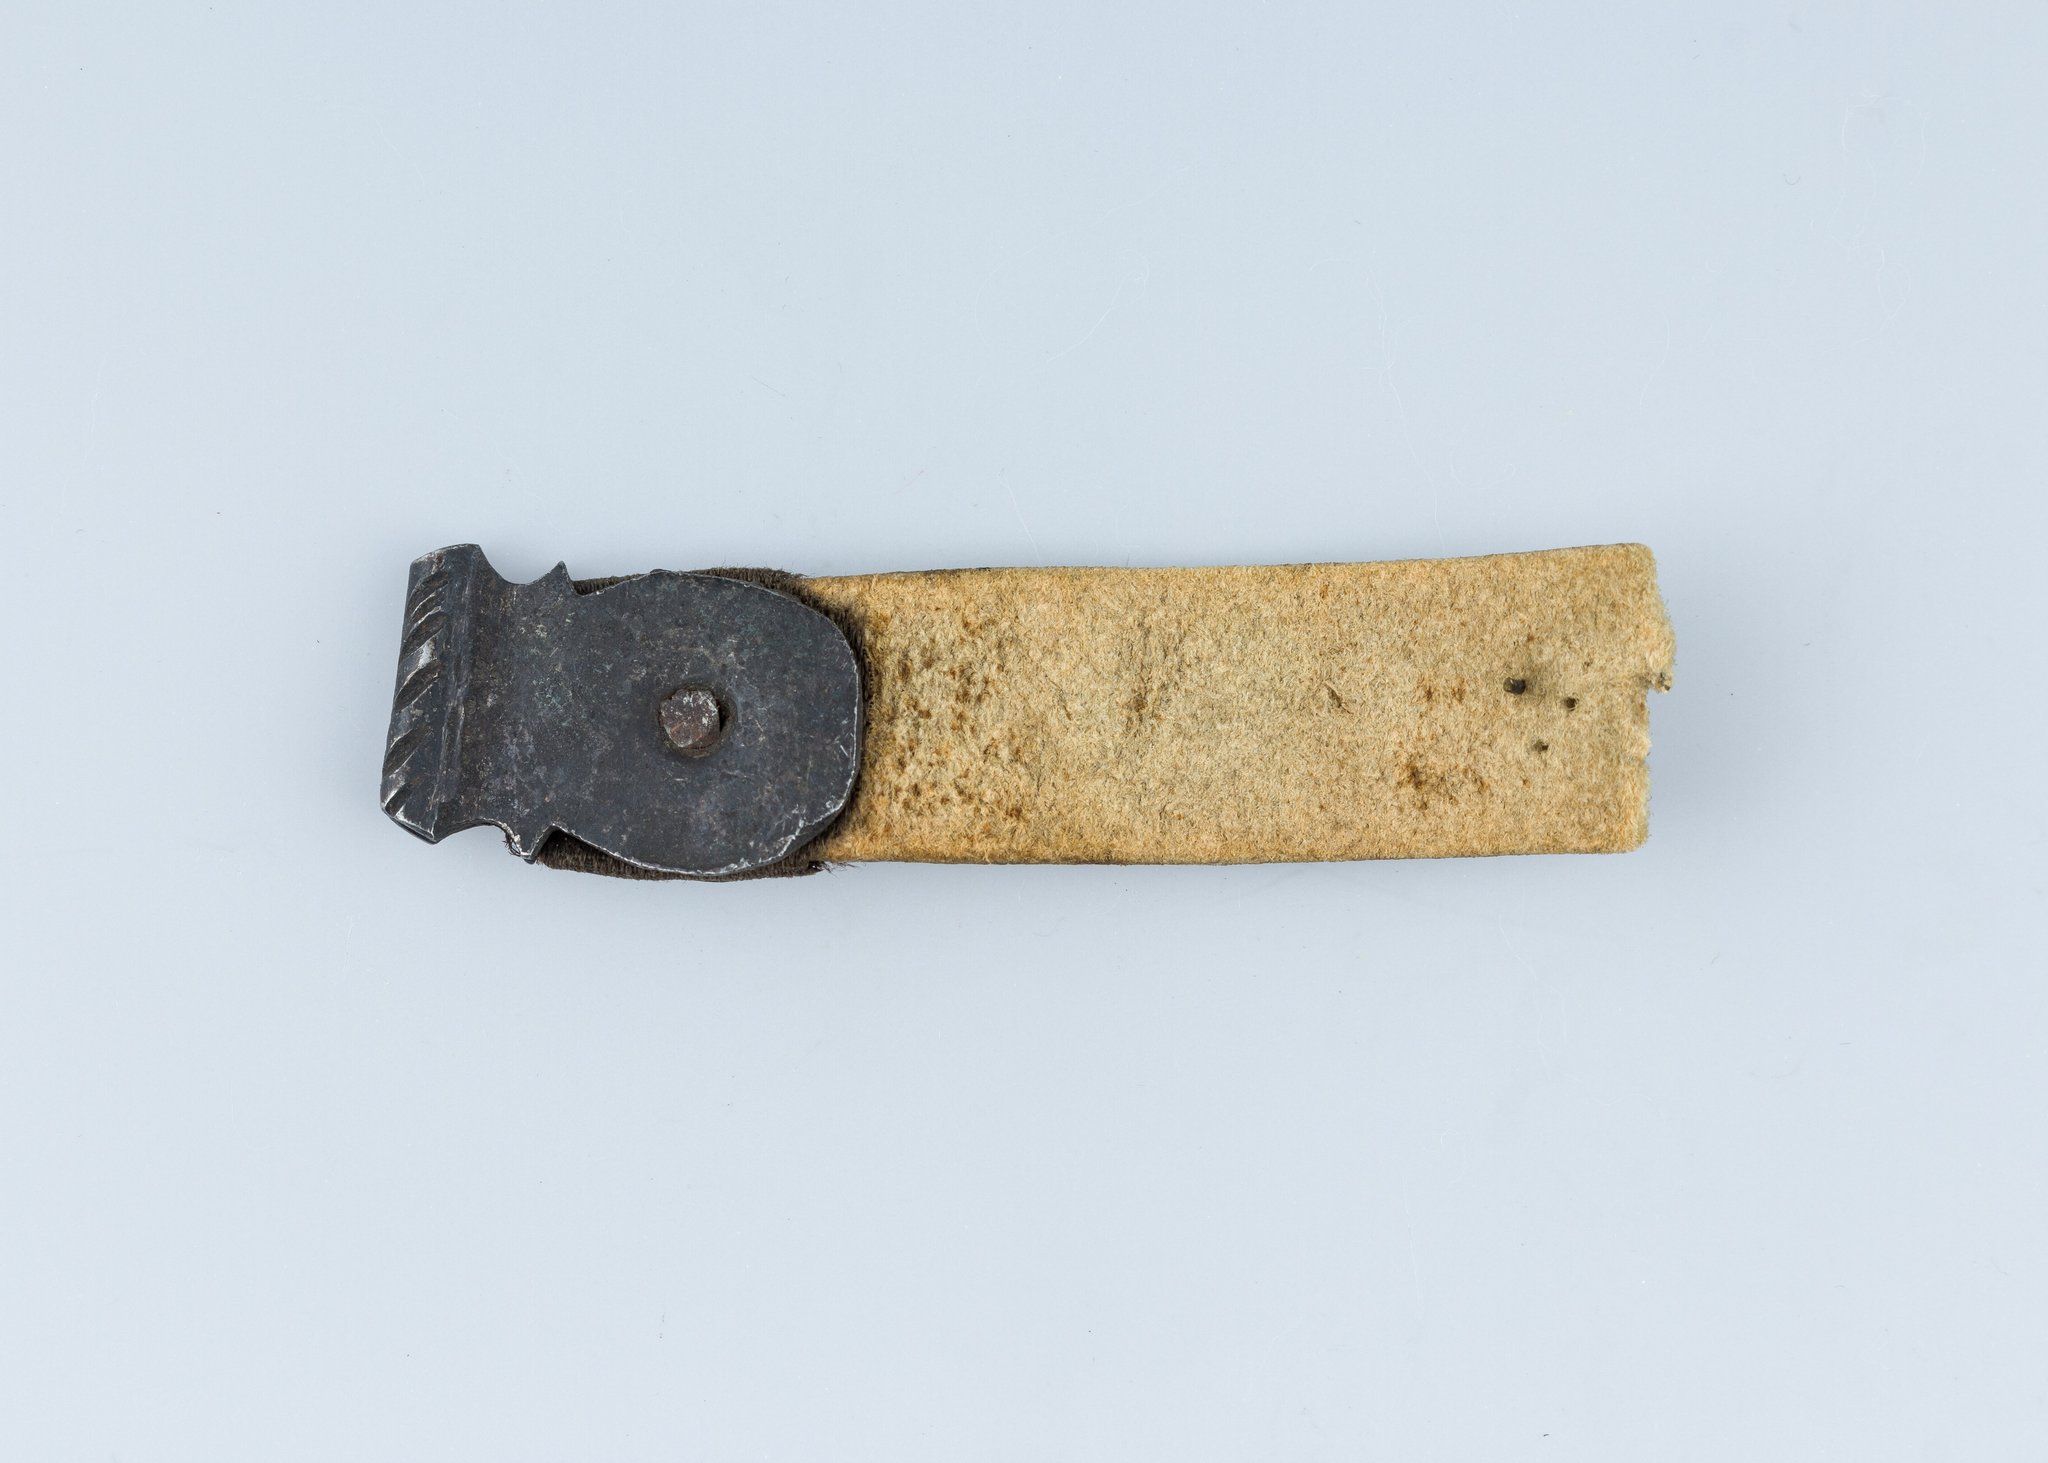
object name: mordant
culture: german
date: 1501-1533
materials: steel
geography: germany